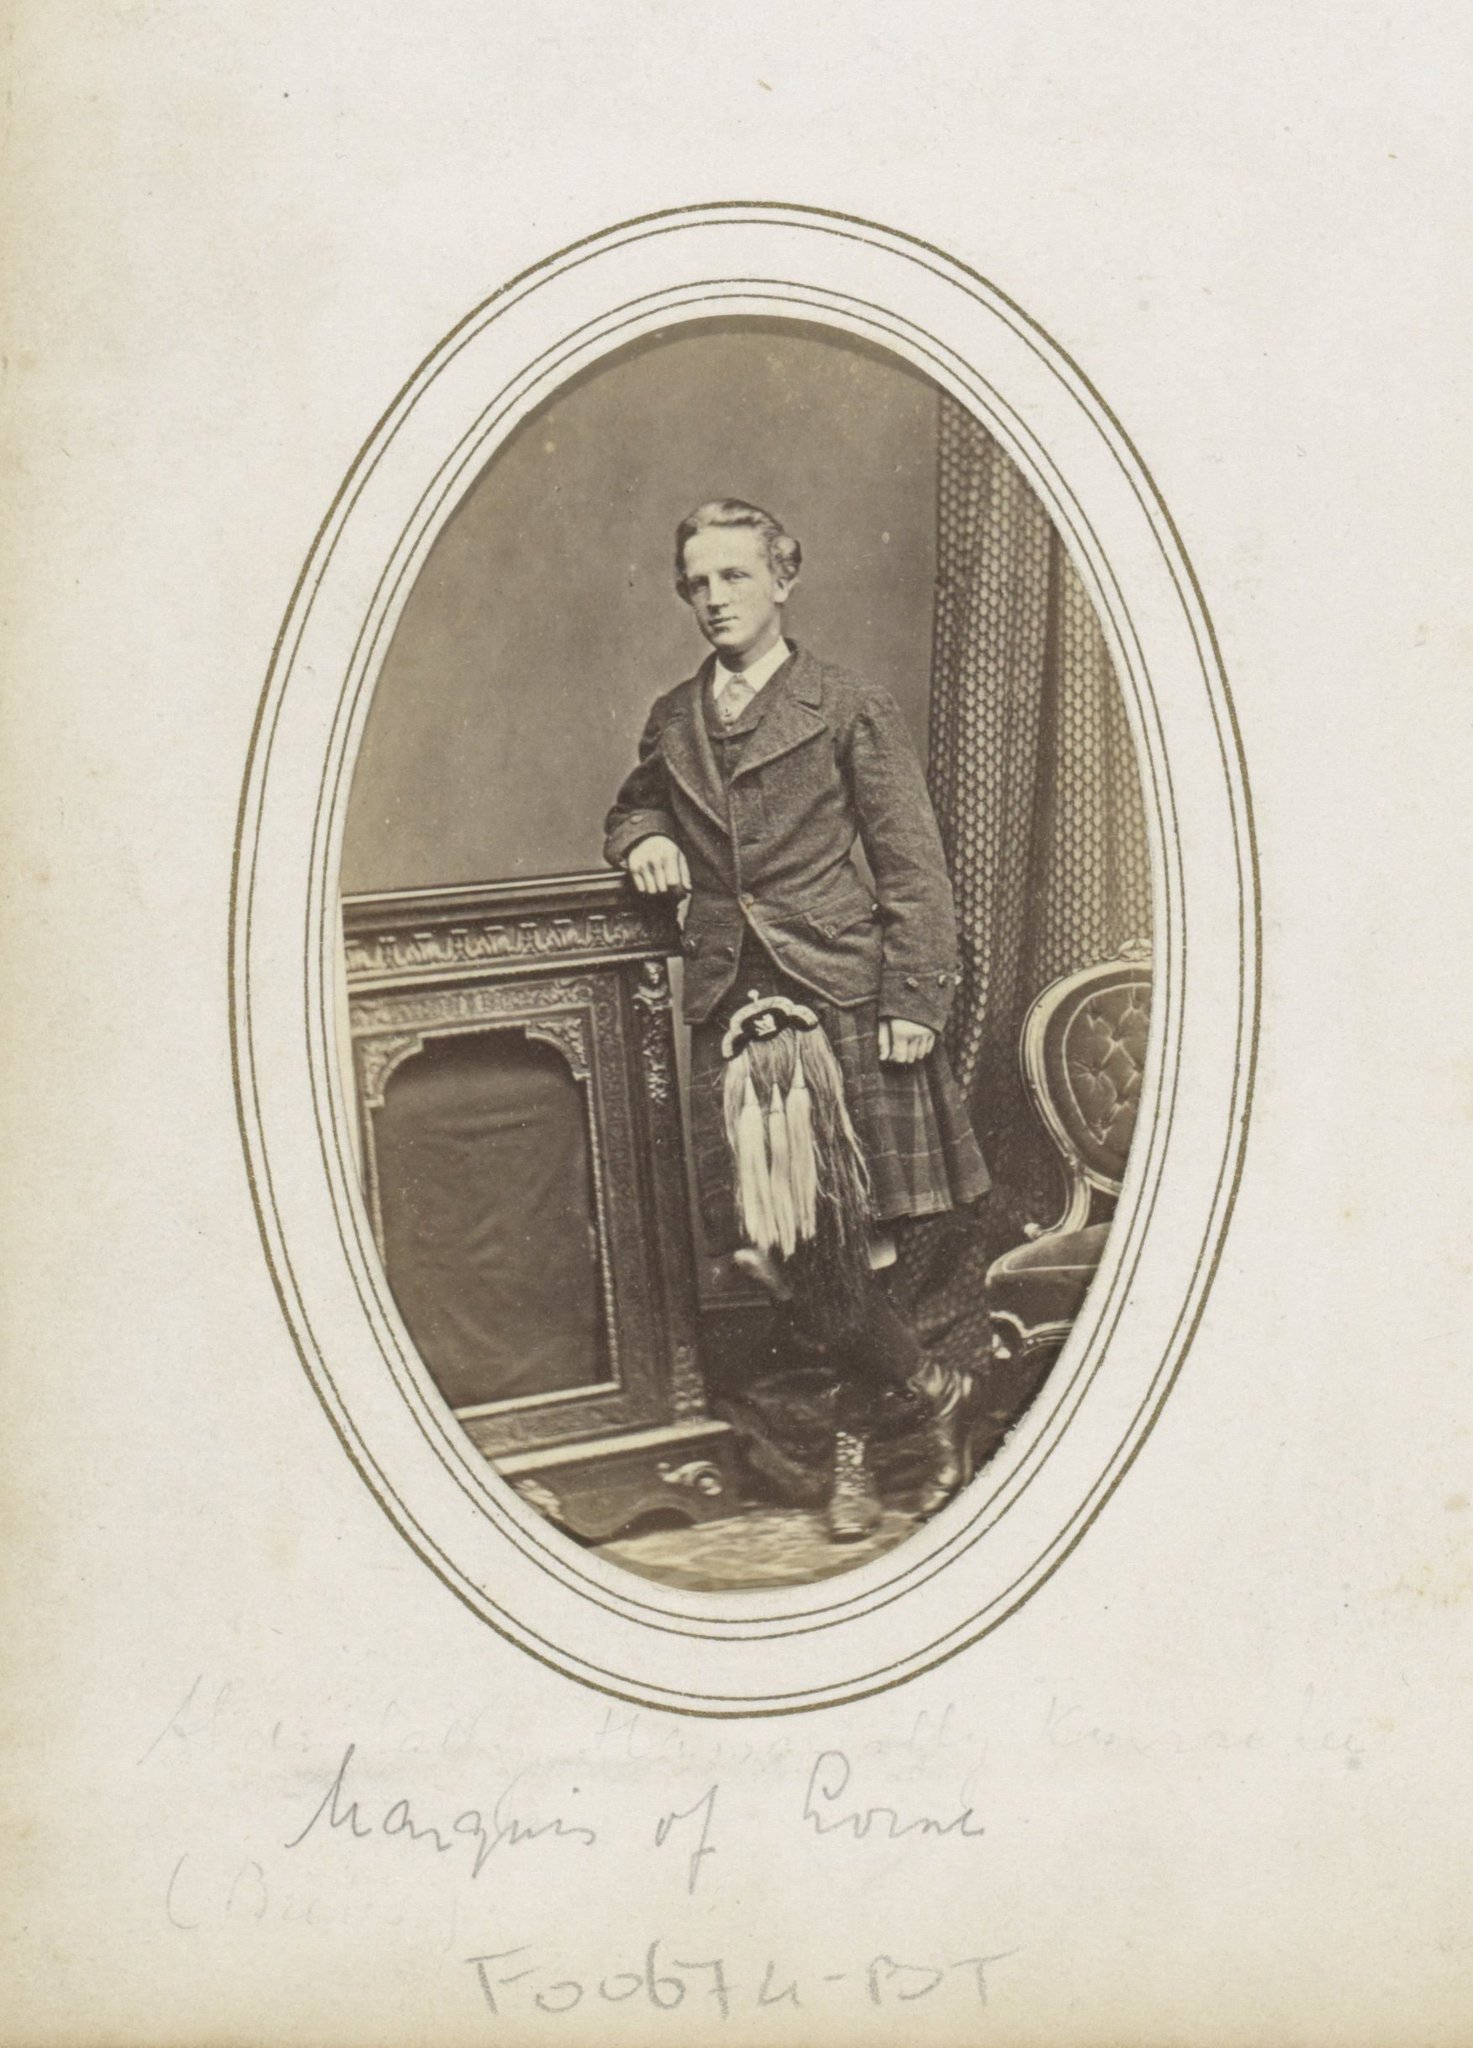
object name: photograph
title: Portret van John Campbell markies van Lorne, in kilt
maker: john stuart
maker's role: fotograaf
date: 1860-1880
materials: cardboard, paper, photographic support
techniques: albumen print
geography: london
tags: john campbell (9th duke of argyll), studio requisites ~ photographer, skirt (kilt), bag (sporran), historical persons, shoes, sandals (+ men's clothes), clothing for the upper part of the body (jacket) (+ men's clothes)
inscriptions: address: ‘120 Buchanan Street, Glasgow’, name: ‘Marion and Co. London’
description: Onderdeel van Fotoalbum met 123 cartes-de-visite van leden van Europese vorstenhuizen, politici en bekende personen.